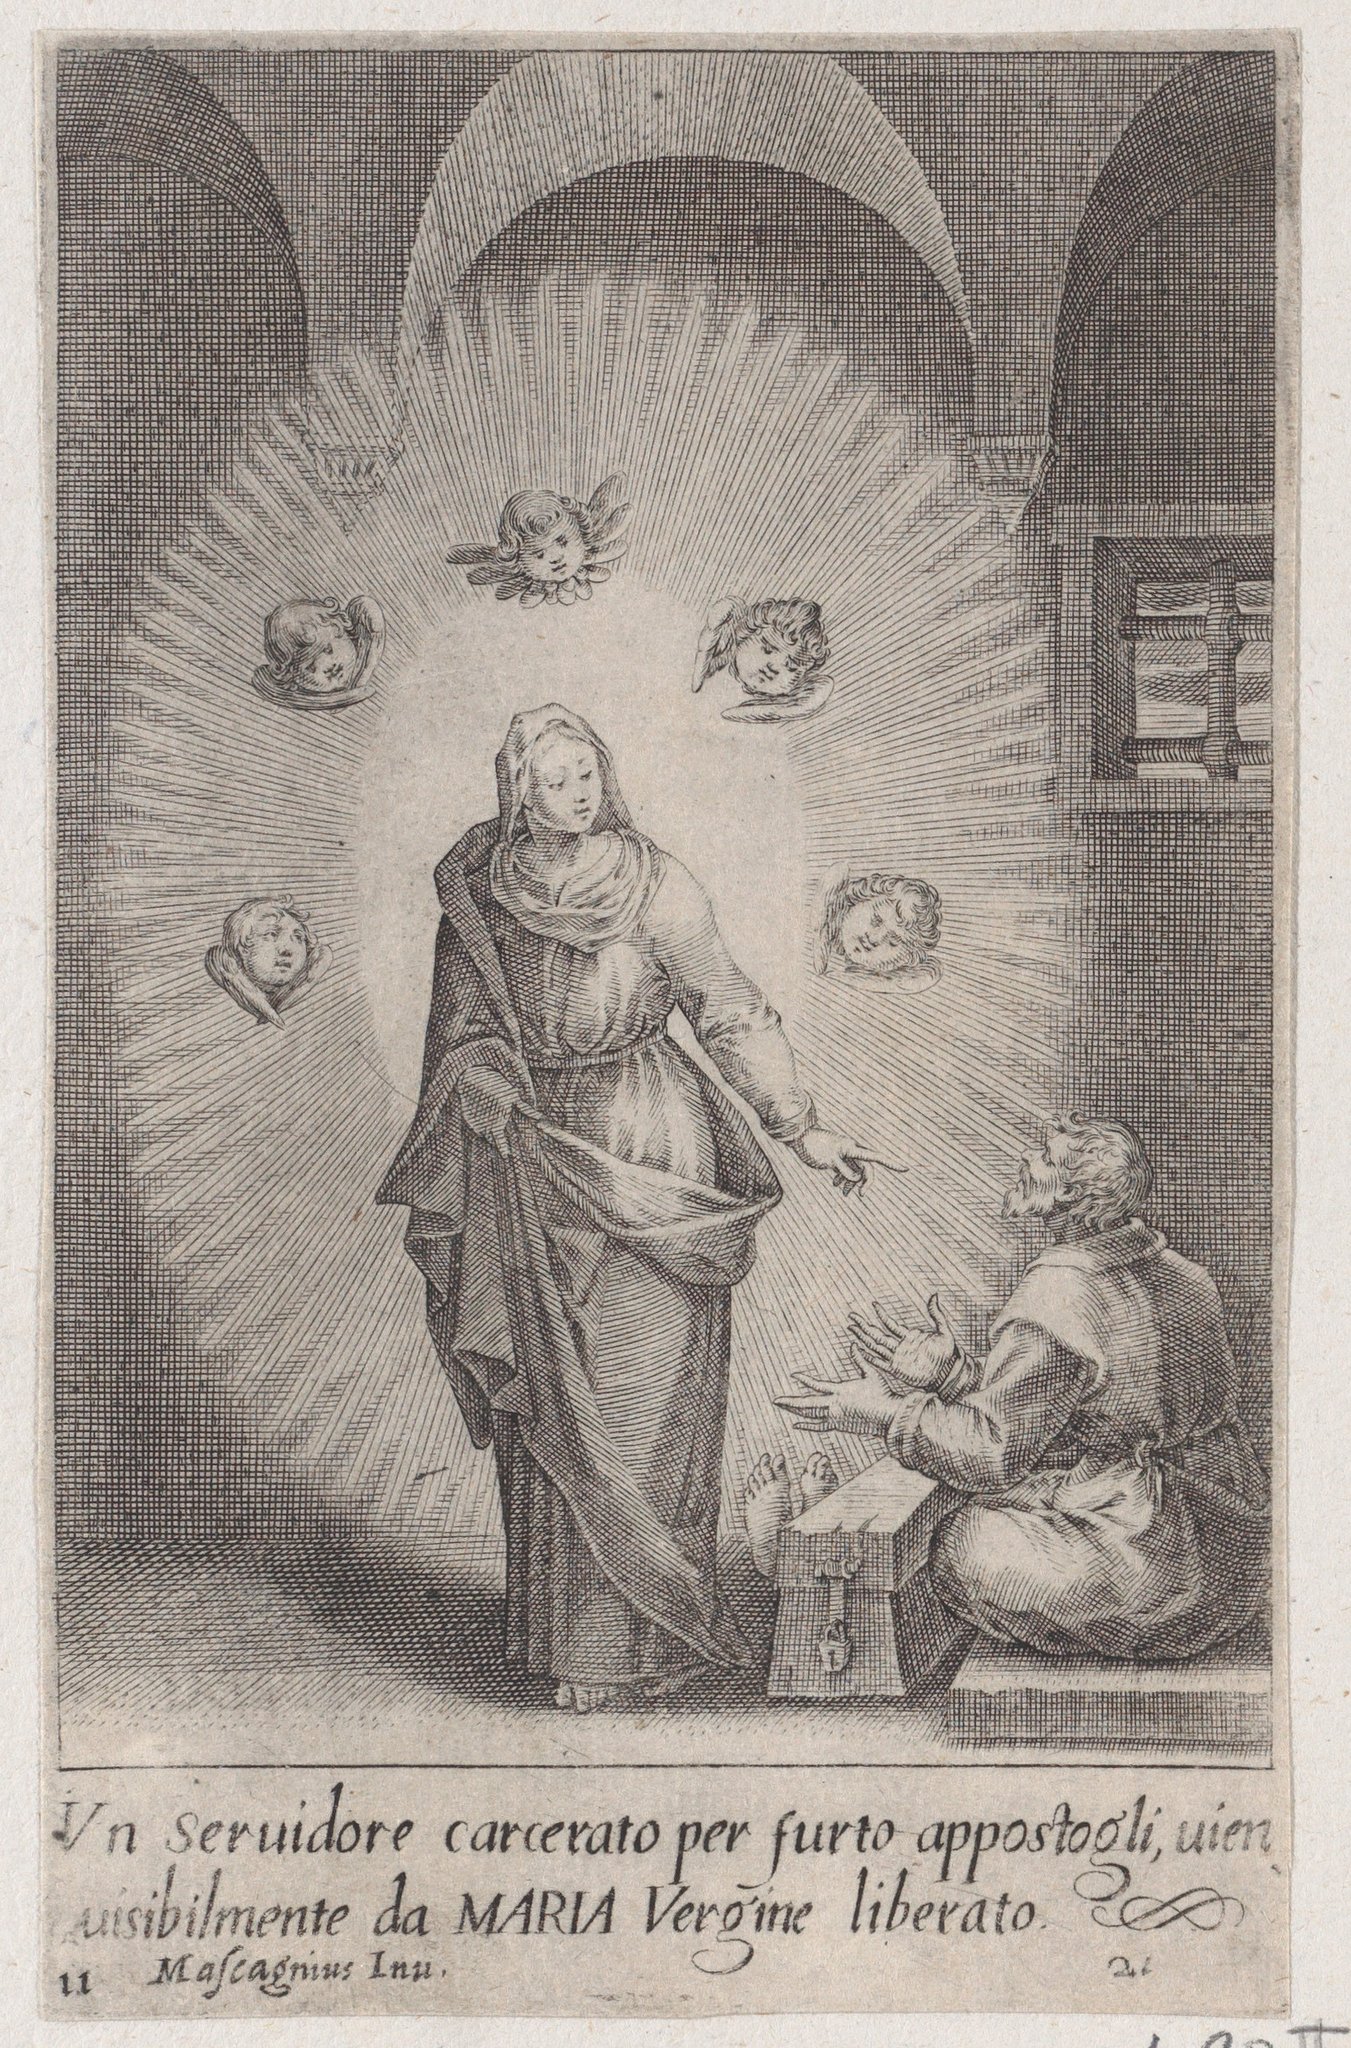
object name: print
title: The Servant Set Free, from Scelta d'Alcuni Miracoli e Grazie della Santissima Nunziata di Firenze (Selection of Some Miracles and Graces that Occurred in the Church of the Annunziata in Florence)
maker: jacques callot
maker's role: artist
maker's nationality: french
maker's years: 1592-1635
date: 1611-1619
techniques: engraving